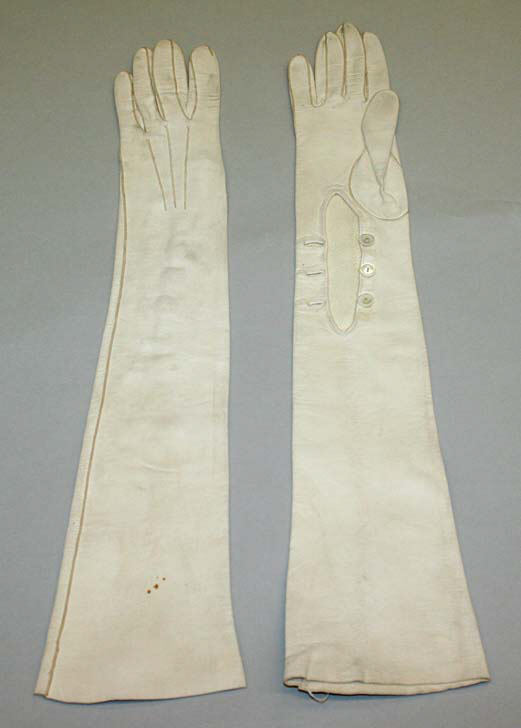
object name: glove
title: Gloves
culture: french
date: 1900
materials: leather